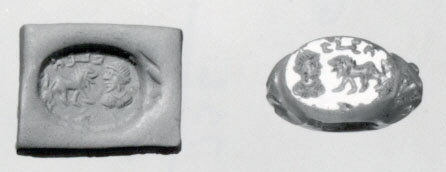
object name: stamp seal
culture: sasanian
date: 201-700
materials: gemstone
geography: iran or mesopotamia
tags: lions